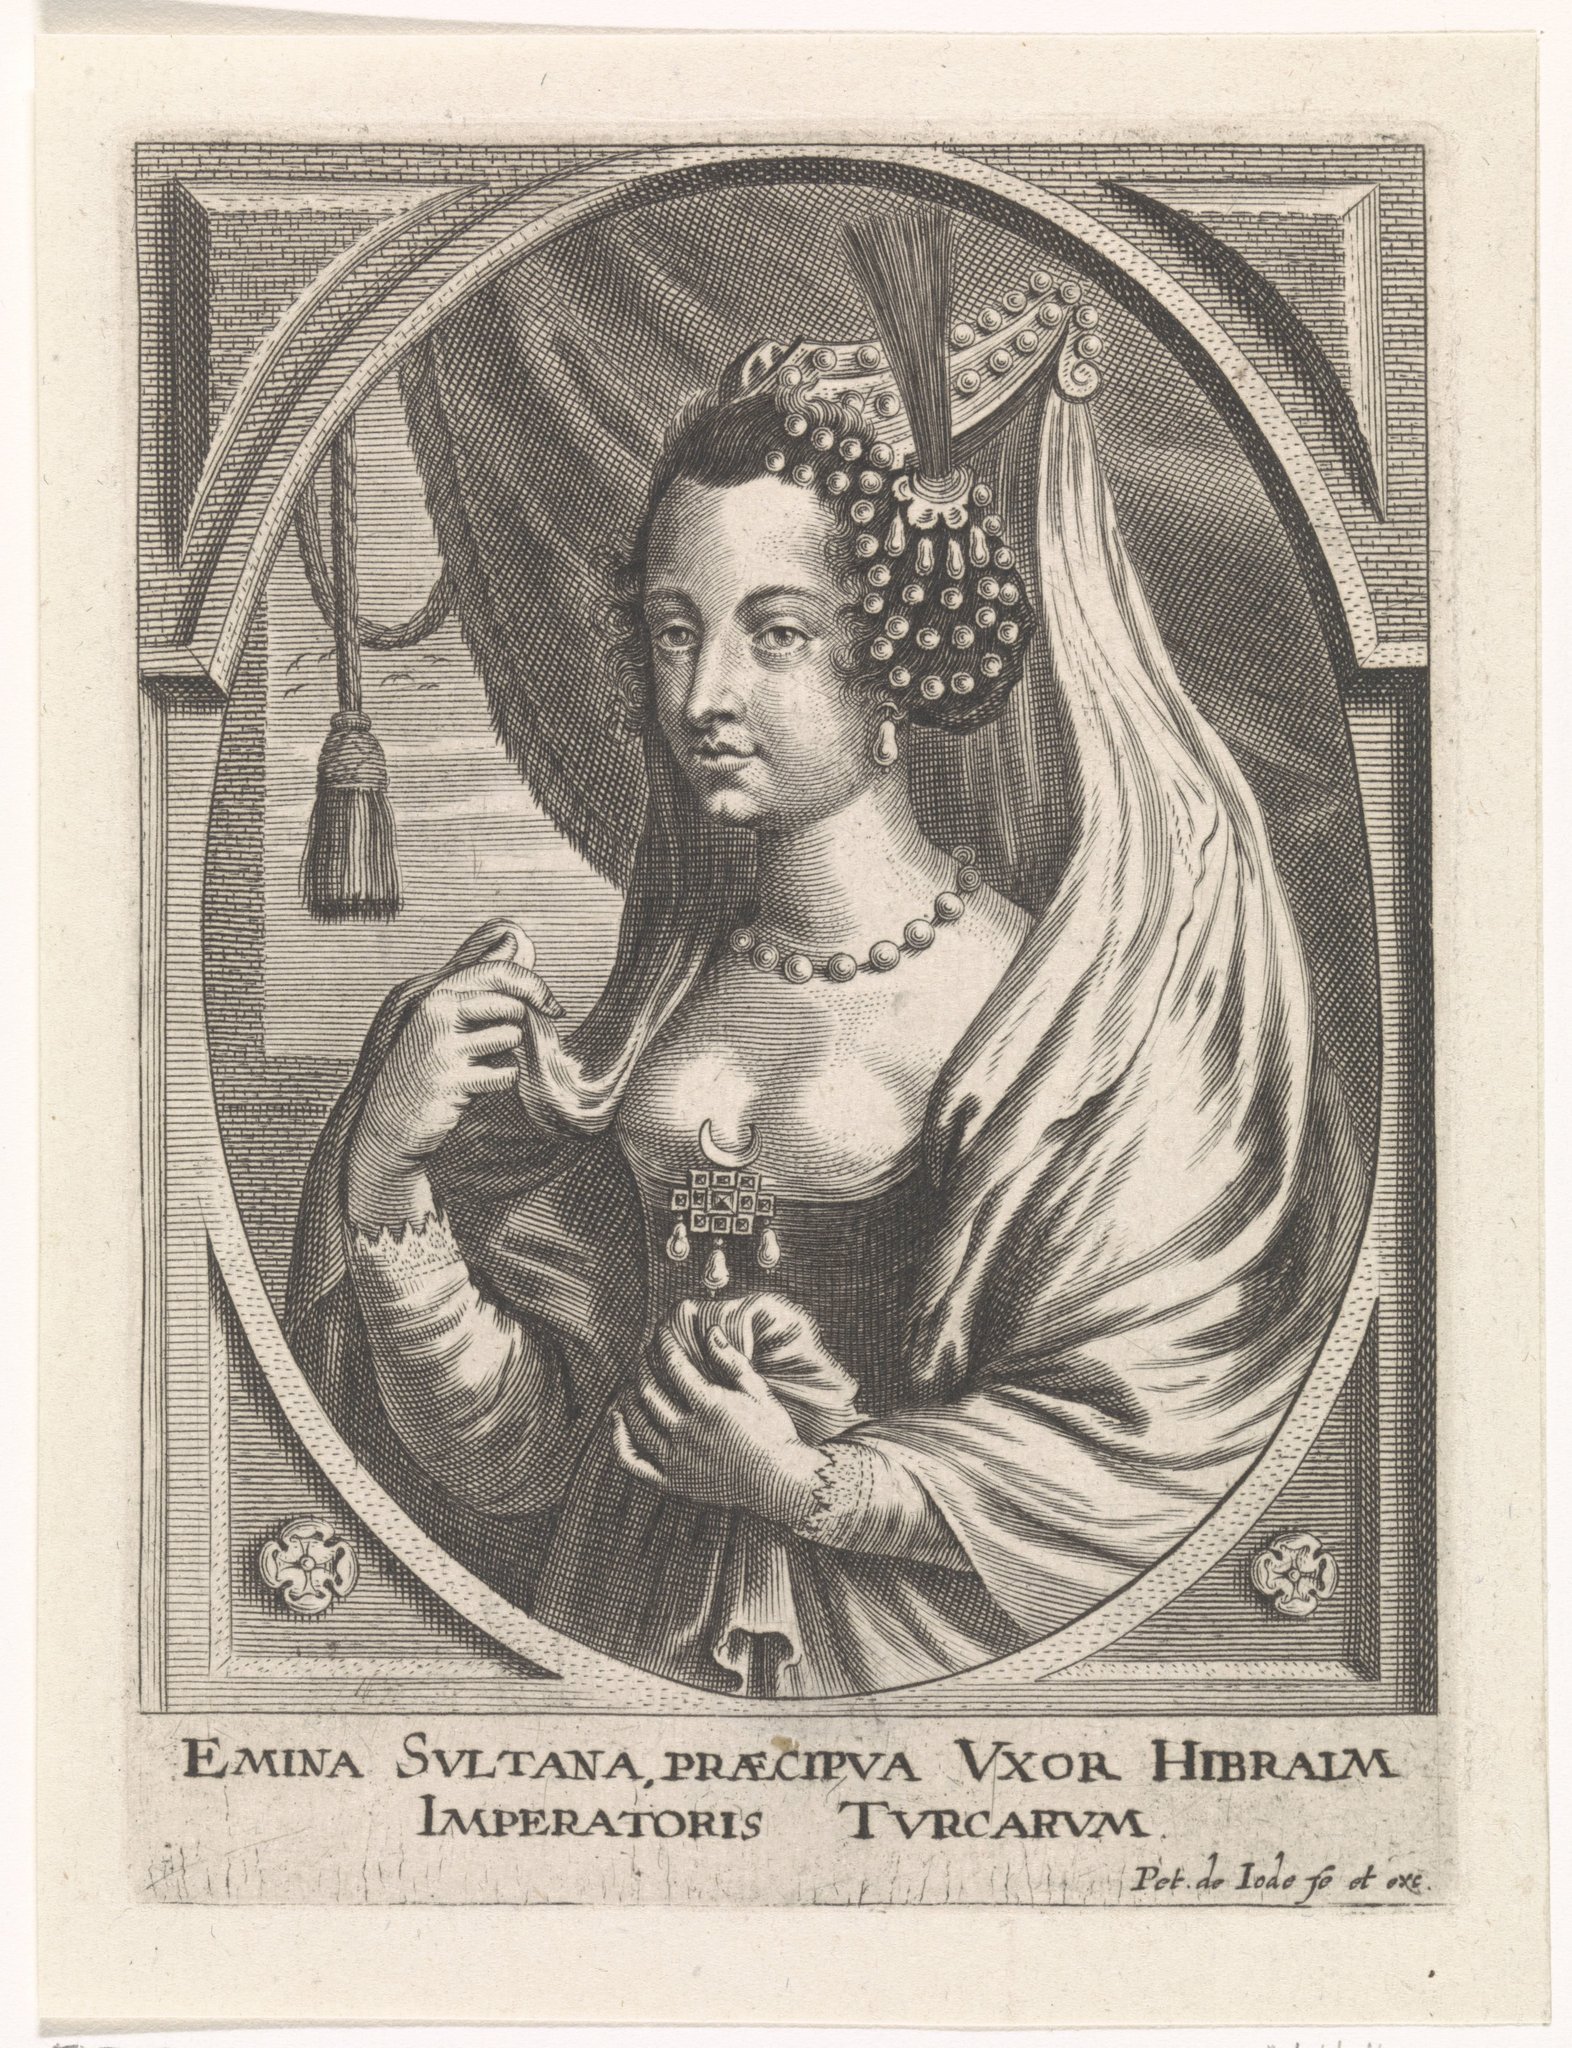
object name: print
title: Theatrum pontificum, imperatorum, regum, ducum, principum, etc.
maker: pieter de jode (ii)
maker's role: draughtsman, print maker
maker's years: 1606-1674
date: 1628-1670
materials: paper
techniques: engraving, etching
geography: antwerp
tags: prinses, emina sultana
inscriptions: collector's mark: Lugt 2228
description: Portret van Emina Sultana, ten halven lijve. Ze draagt een jurk met decolleté, een sieraad met een halve maan en een sluier. Het portret is gevat in een ovale omlijsting. In de marge een tweeregelig onderschrift in het Latijn.